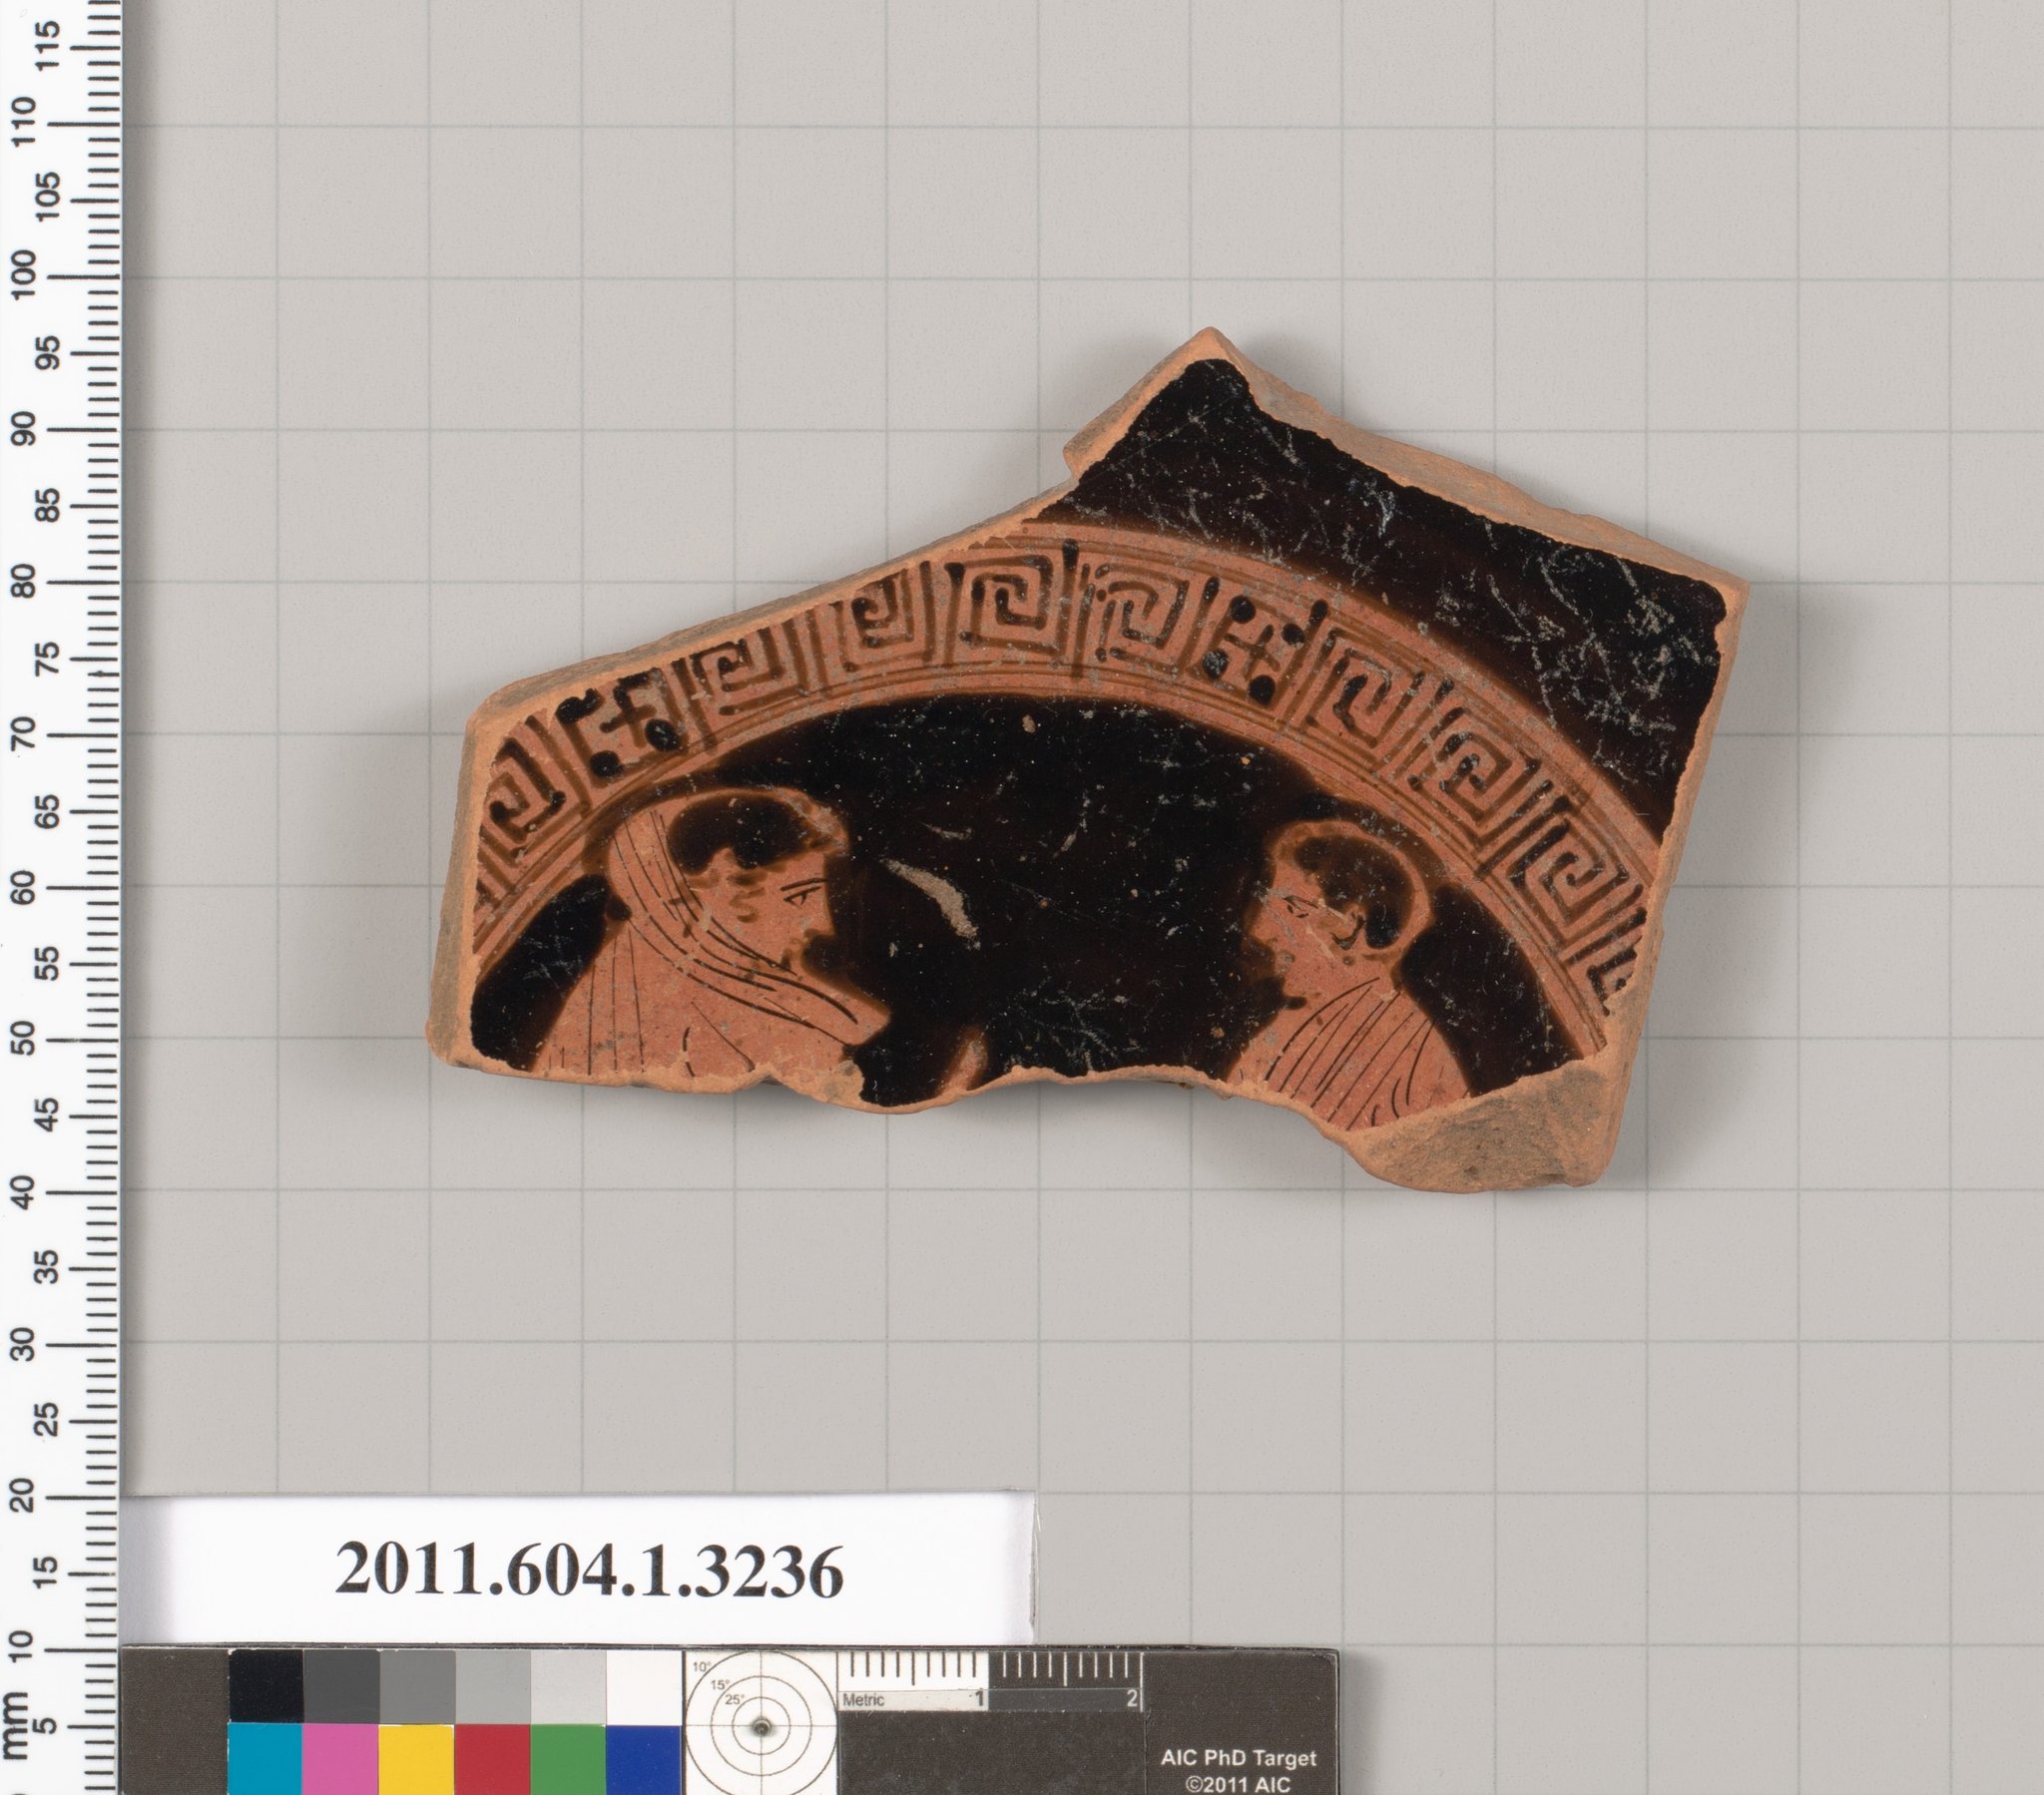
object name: kylix fragment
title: Terracotta fragment of a kylix (drinking cup)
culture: greek, attic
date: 467-435 BCE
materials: terracotta